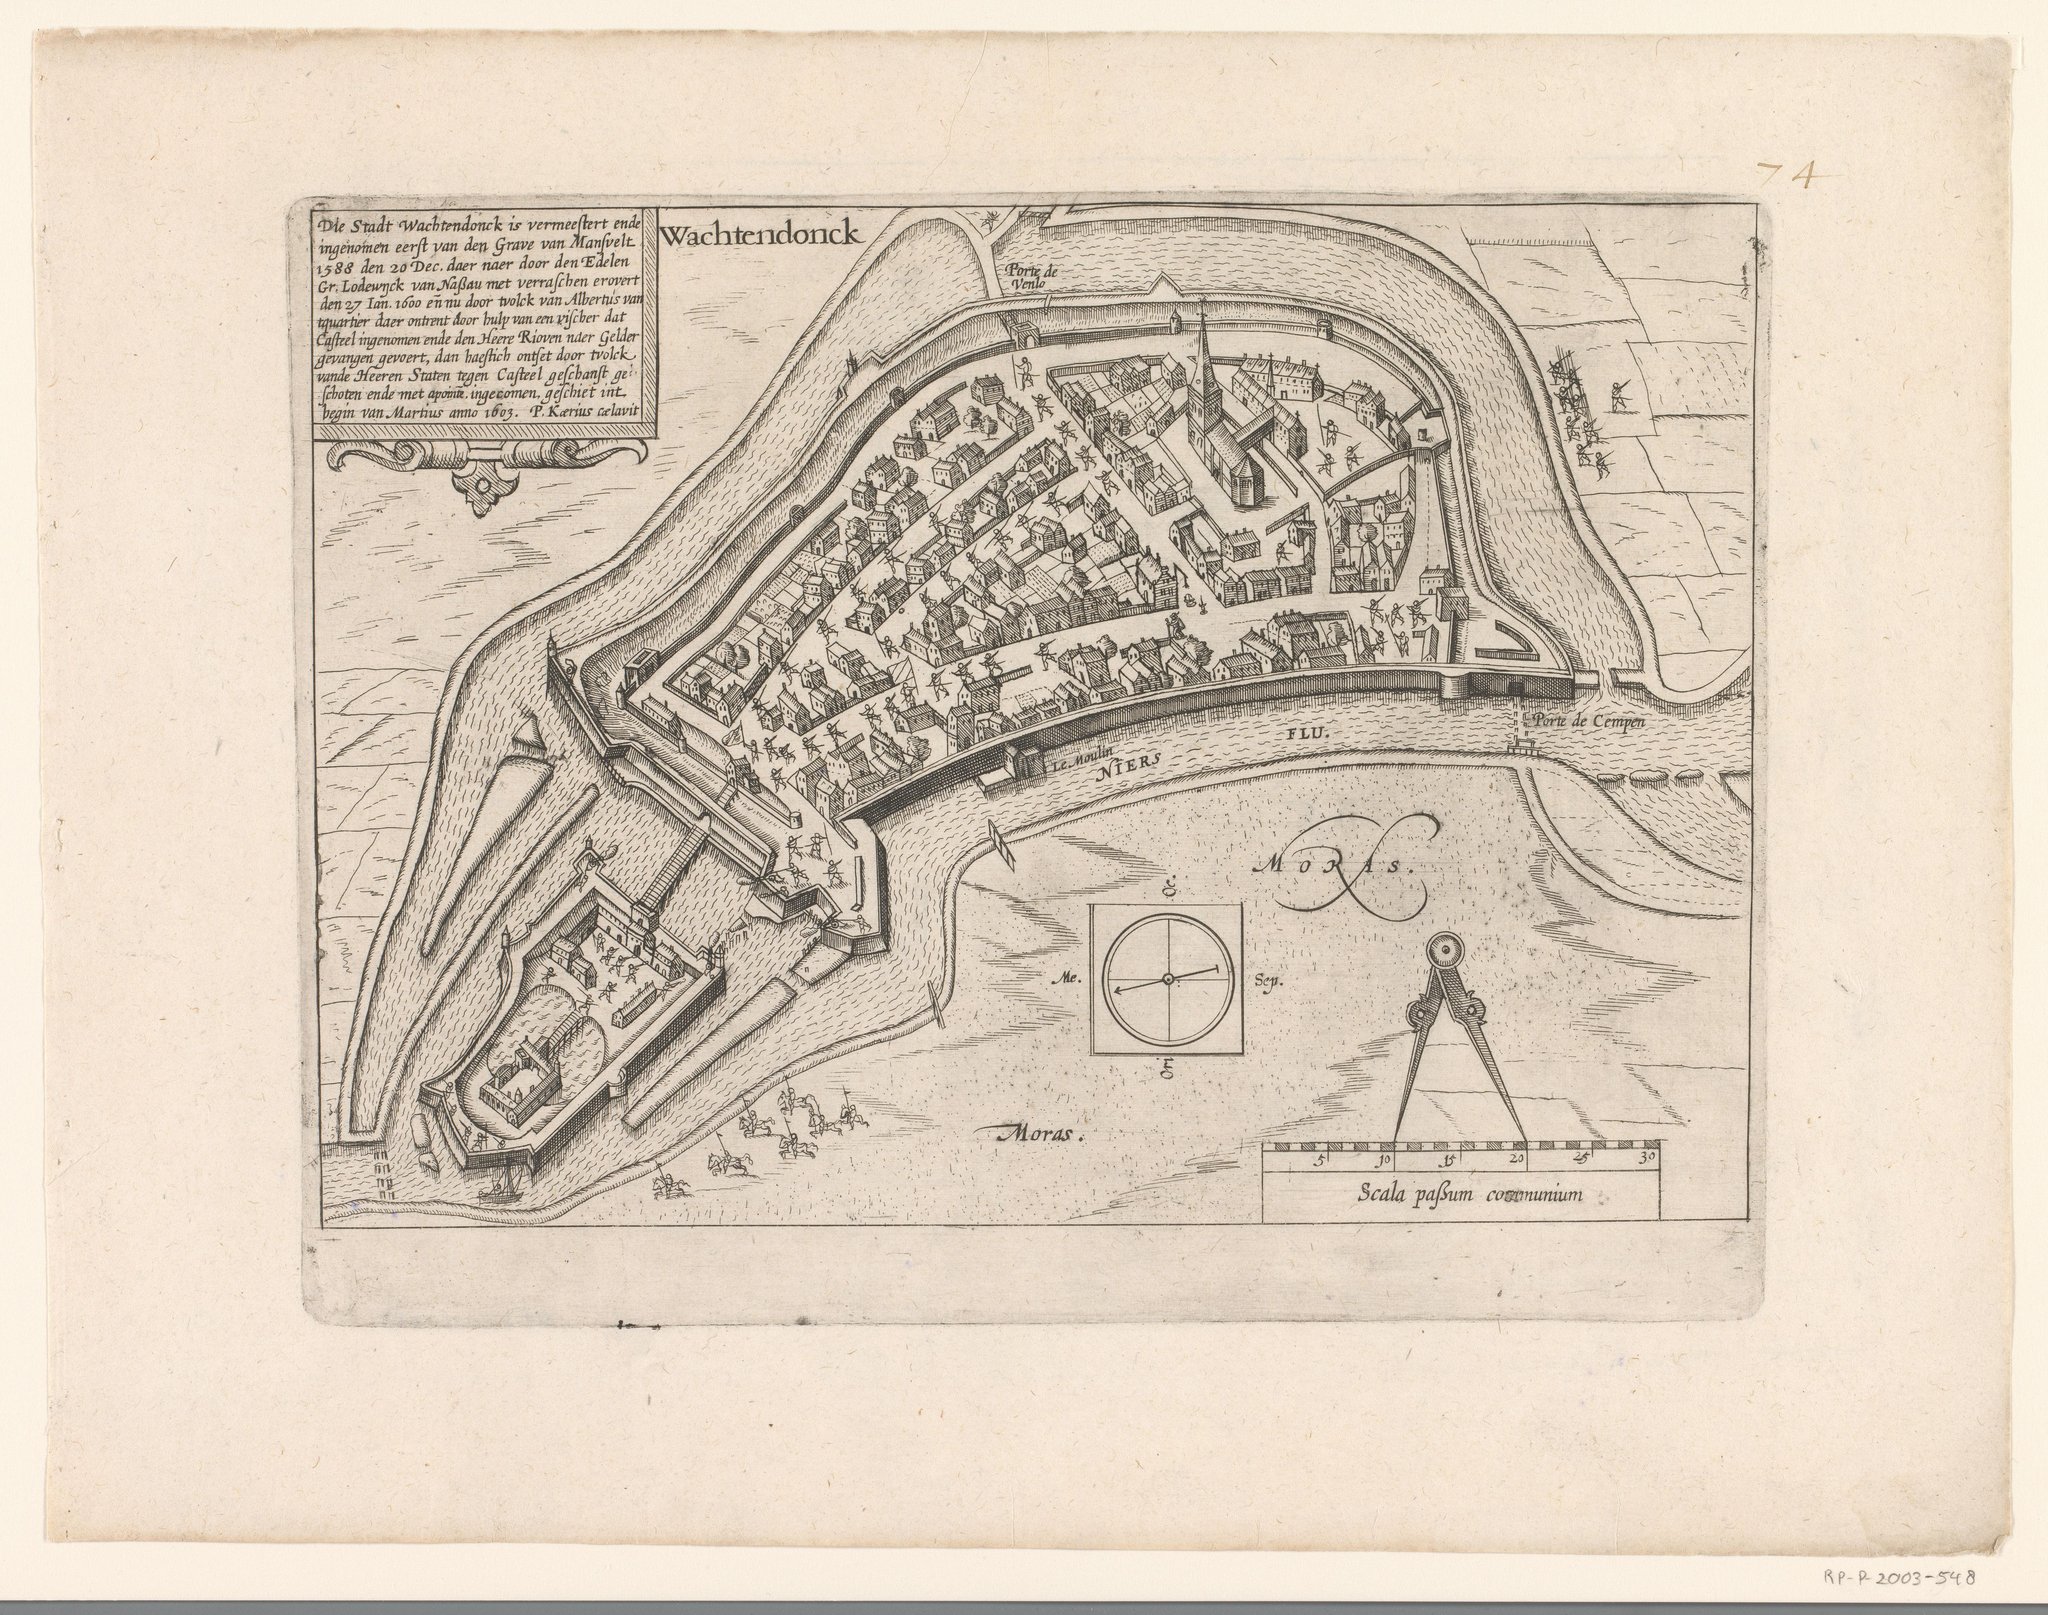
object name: history print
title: Wachtendonk bezet door de Spanjaarden, 1603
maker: pieter van der keere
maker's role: print maker, publisher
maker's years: 1571-1646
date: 1607-1609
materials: paper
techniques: engraving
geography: northern netherlands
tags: capture of city (after the siege), maps of cities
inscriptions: number: ‘74’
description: Het kasteel van Wachtendonk bij list ingenomen door de Spanjaarden en zes dagen lang bezet gehouden, 5-11 maart 1603. Plattegrond van de stad in vogelvlucht en de gevechten rond het kasteel, links. Linksboven een cartouche met opschrift in het Nederlands over de veroveringen tussen 1588-1603 en de naam van de maker, rechtsonder een passer met schaalstok en een kompasroos. Onderdeel van de verzameling kaarten genomen uit een latere editie van: Descrittione di tutti i Paesi Bassi van Lodovico Guicciardini.